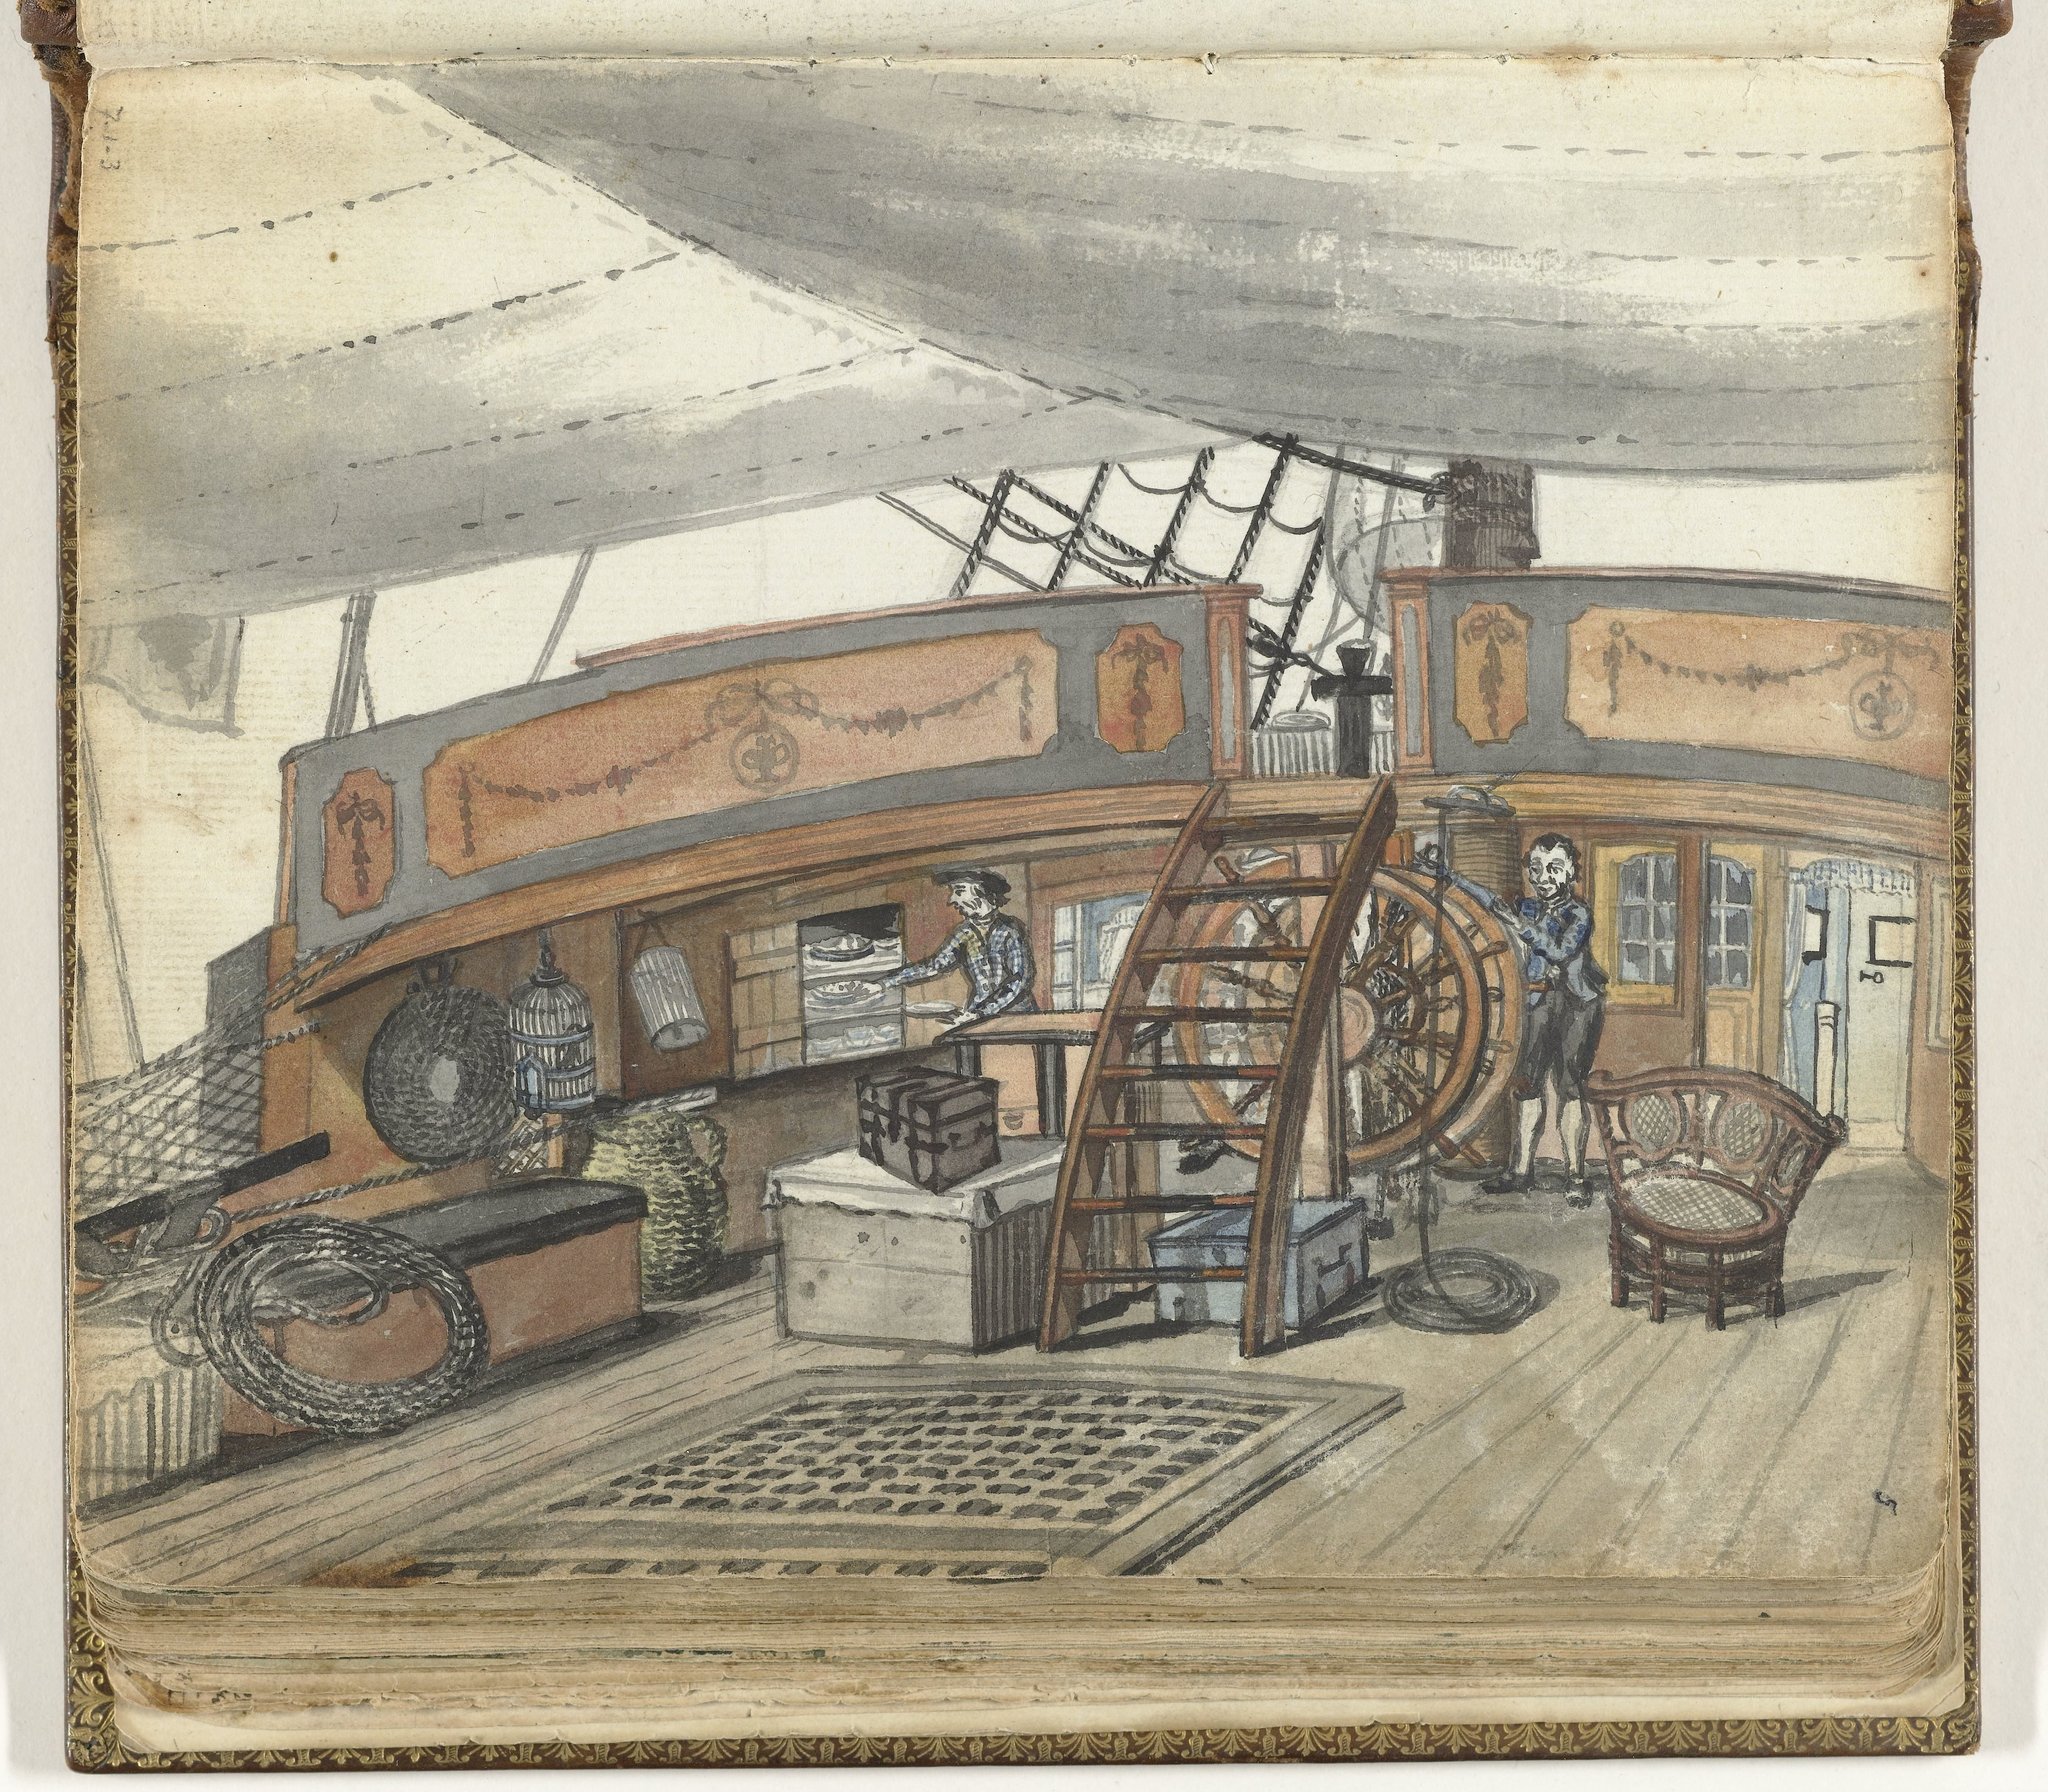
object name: drawing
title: Dekzicht van een Oost-Indiëvaarder met stuurman aan het roer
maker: jan brandes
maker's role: draughtsman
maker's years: 1743-1808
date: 1779-1787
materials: paper, pencil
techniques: brush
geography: indian ocean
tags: sailing-ship, sailing-boat, parts of ship's exterior: deck, at the helm (manoeuvering)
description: Kleurtekening van het halfdek gezien van de grote mast naar de bezaanmast. Zichtbaar zijn een deel van de bolstaande zeilen, tuig en want. Op het dek staan kisten en een stoel. De stuurman draait het stuurwiel. Een bediende haalt servies voor de deels zichtbare officiersverblijven. Ter rechterzijde ontbreekt een deel van de tekening. Onderdeel uit het schetsboek van Jan Brandes, dl. 1 (1808), p. 5.